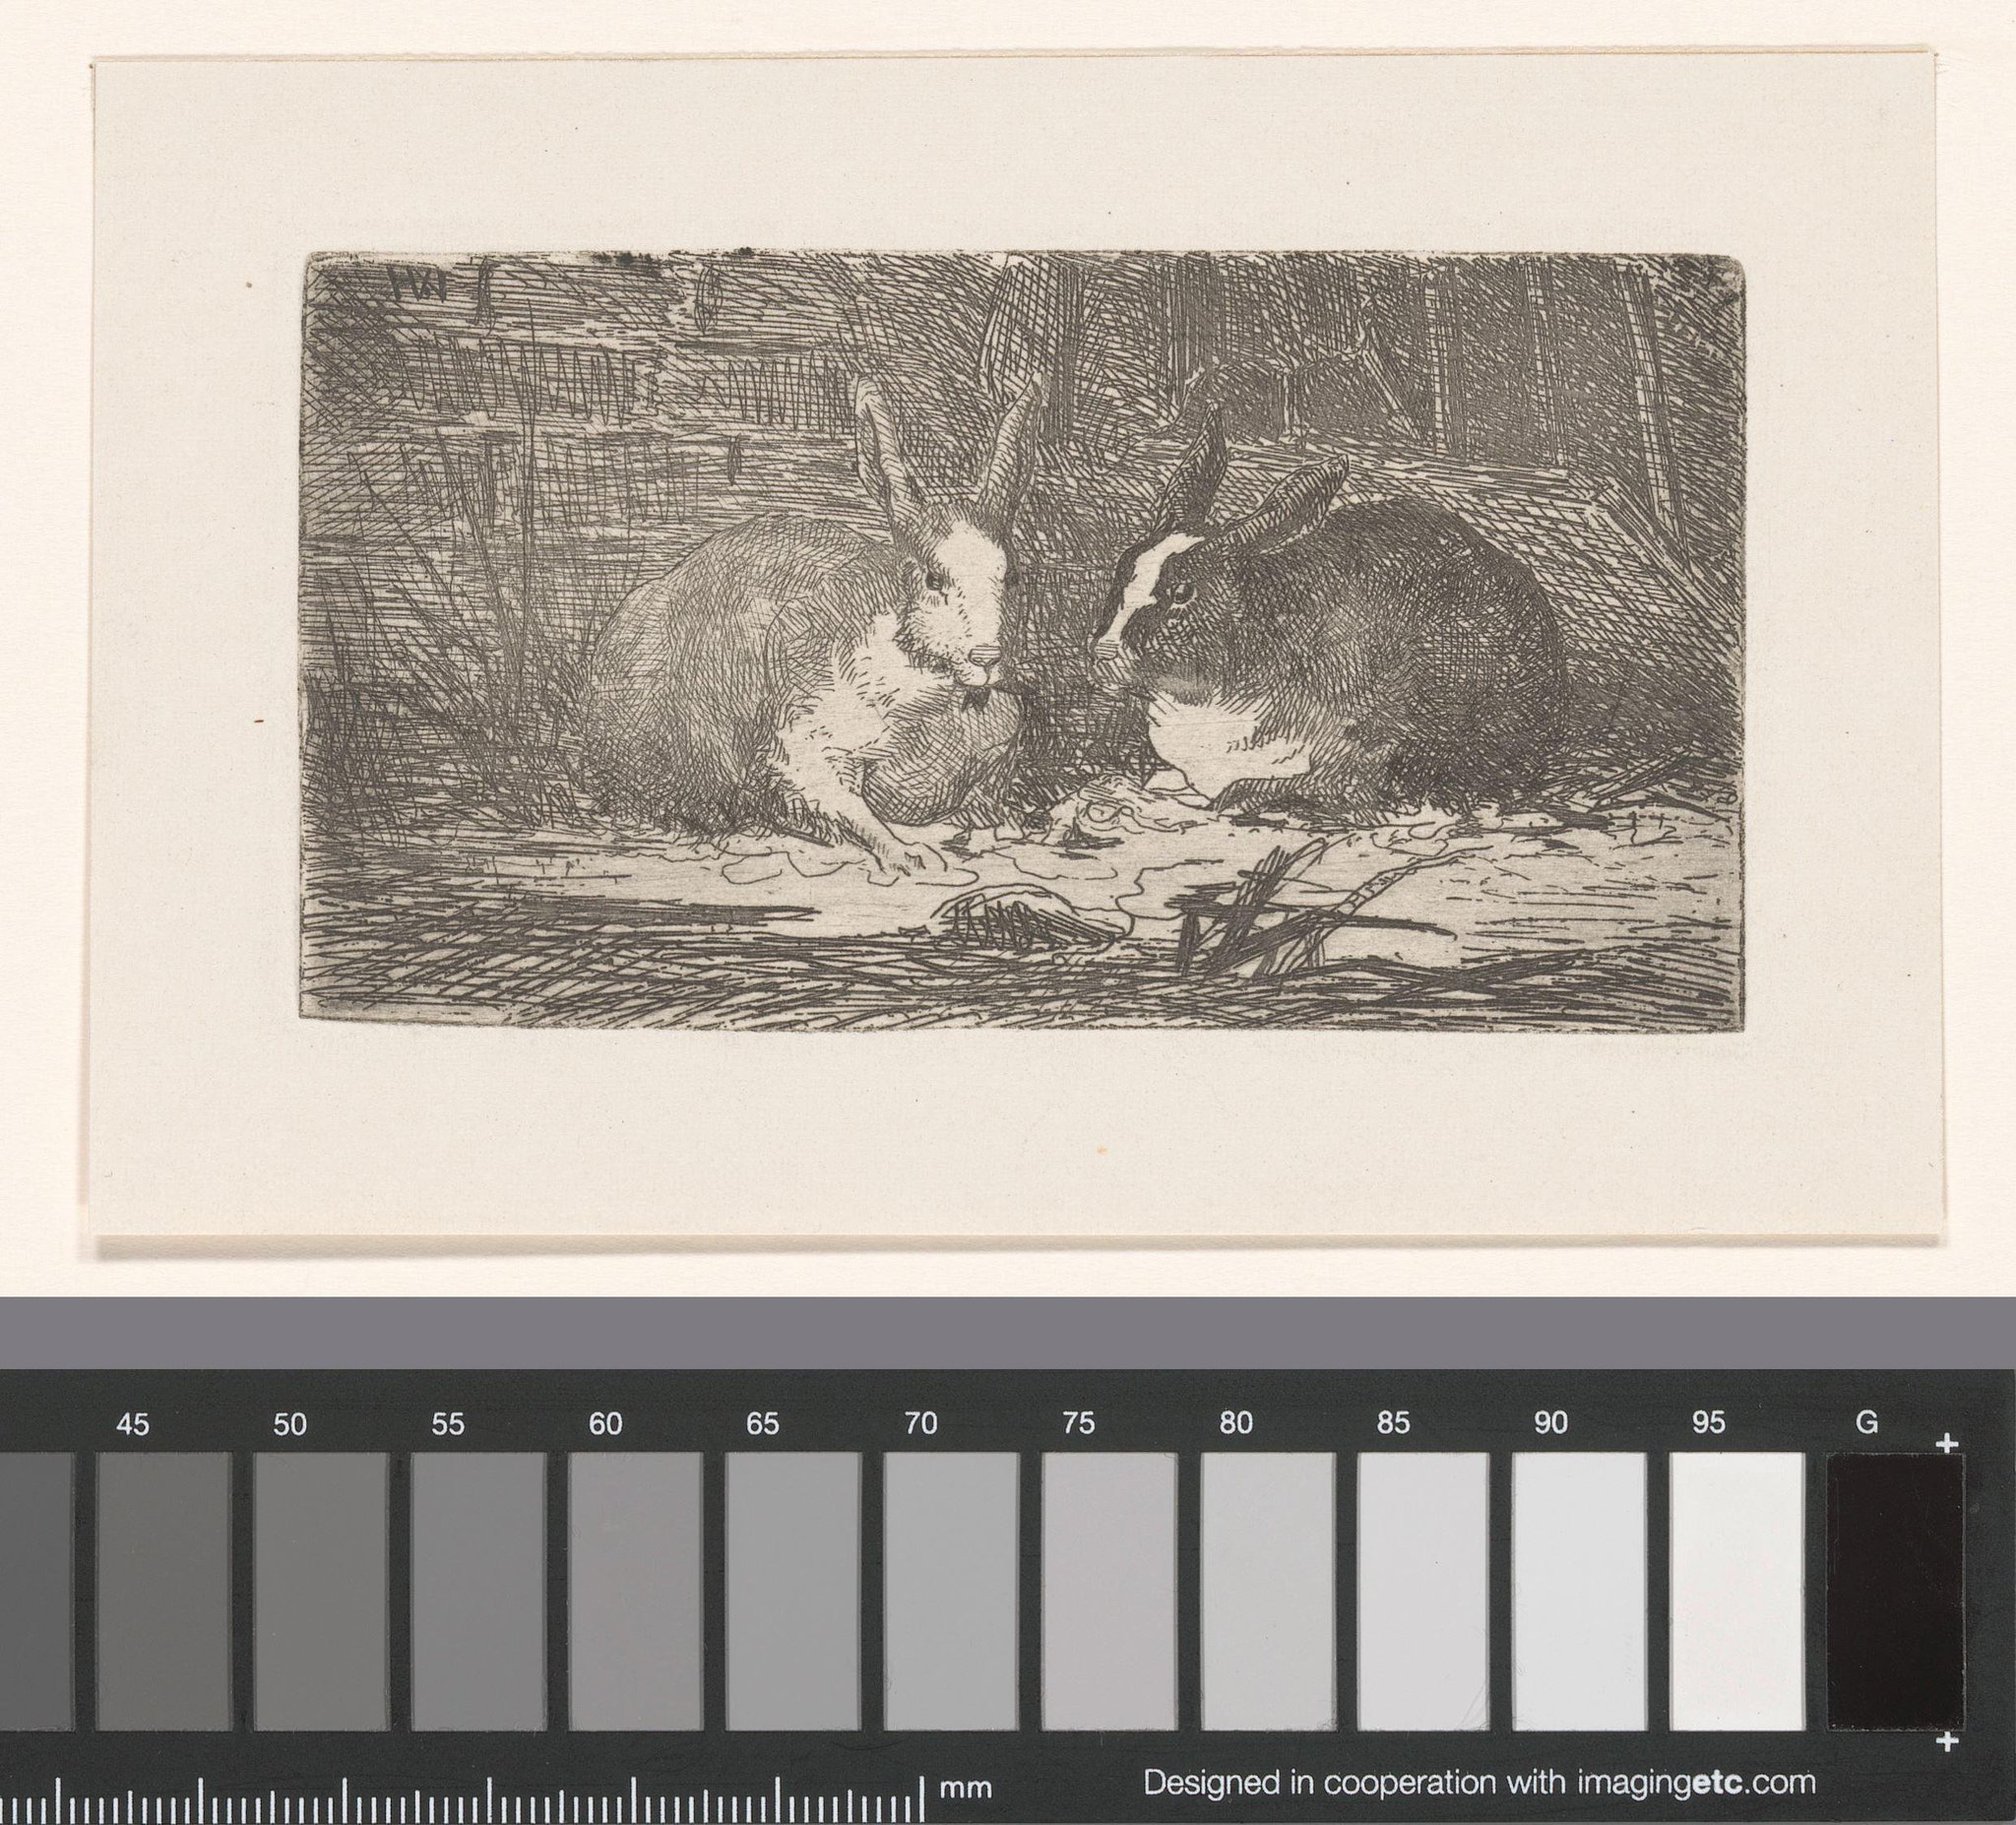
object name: print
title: Twee konijnen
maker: herman johannes van der weele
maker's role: print maker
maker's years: 1852-1930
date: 1862-1930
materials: paper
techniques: etching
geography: netherlands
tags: rodents: rabbit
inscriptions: collector's mark: Lugt 2228, inscription: ‘2e : druk’